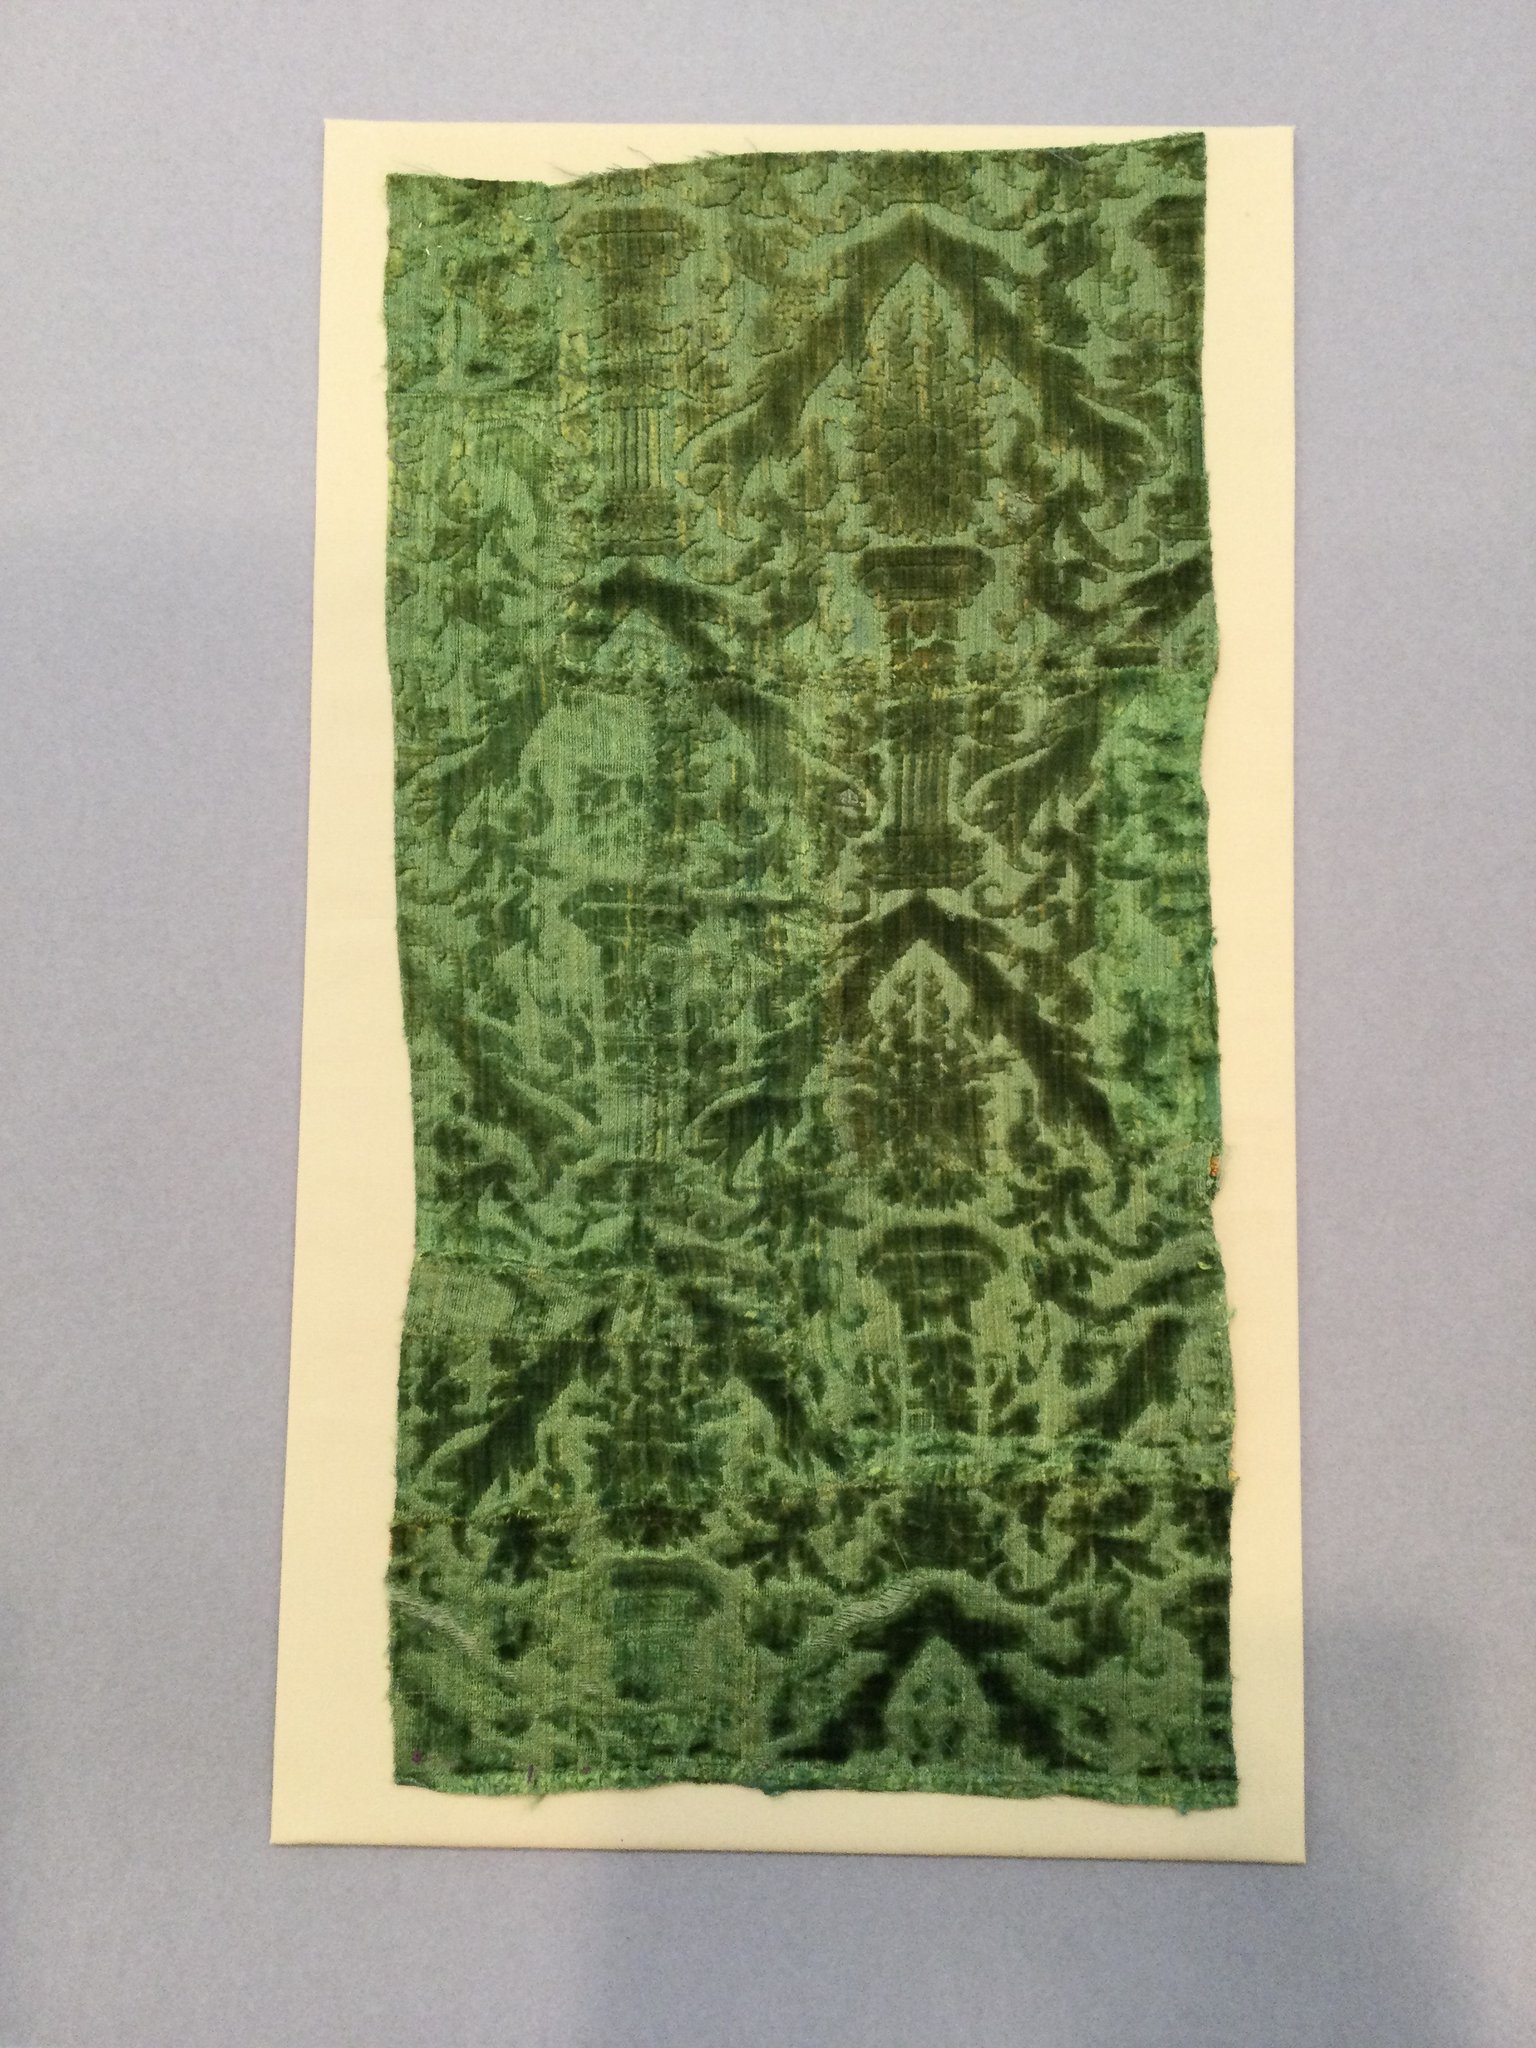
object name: piece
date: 1501-1600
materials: silk